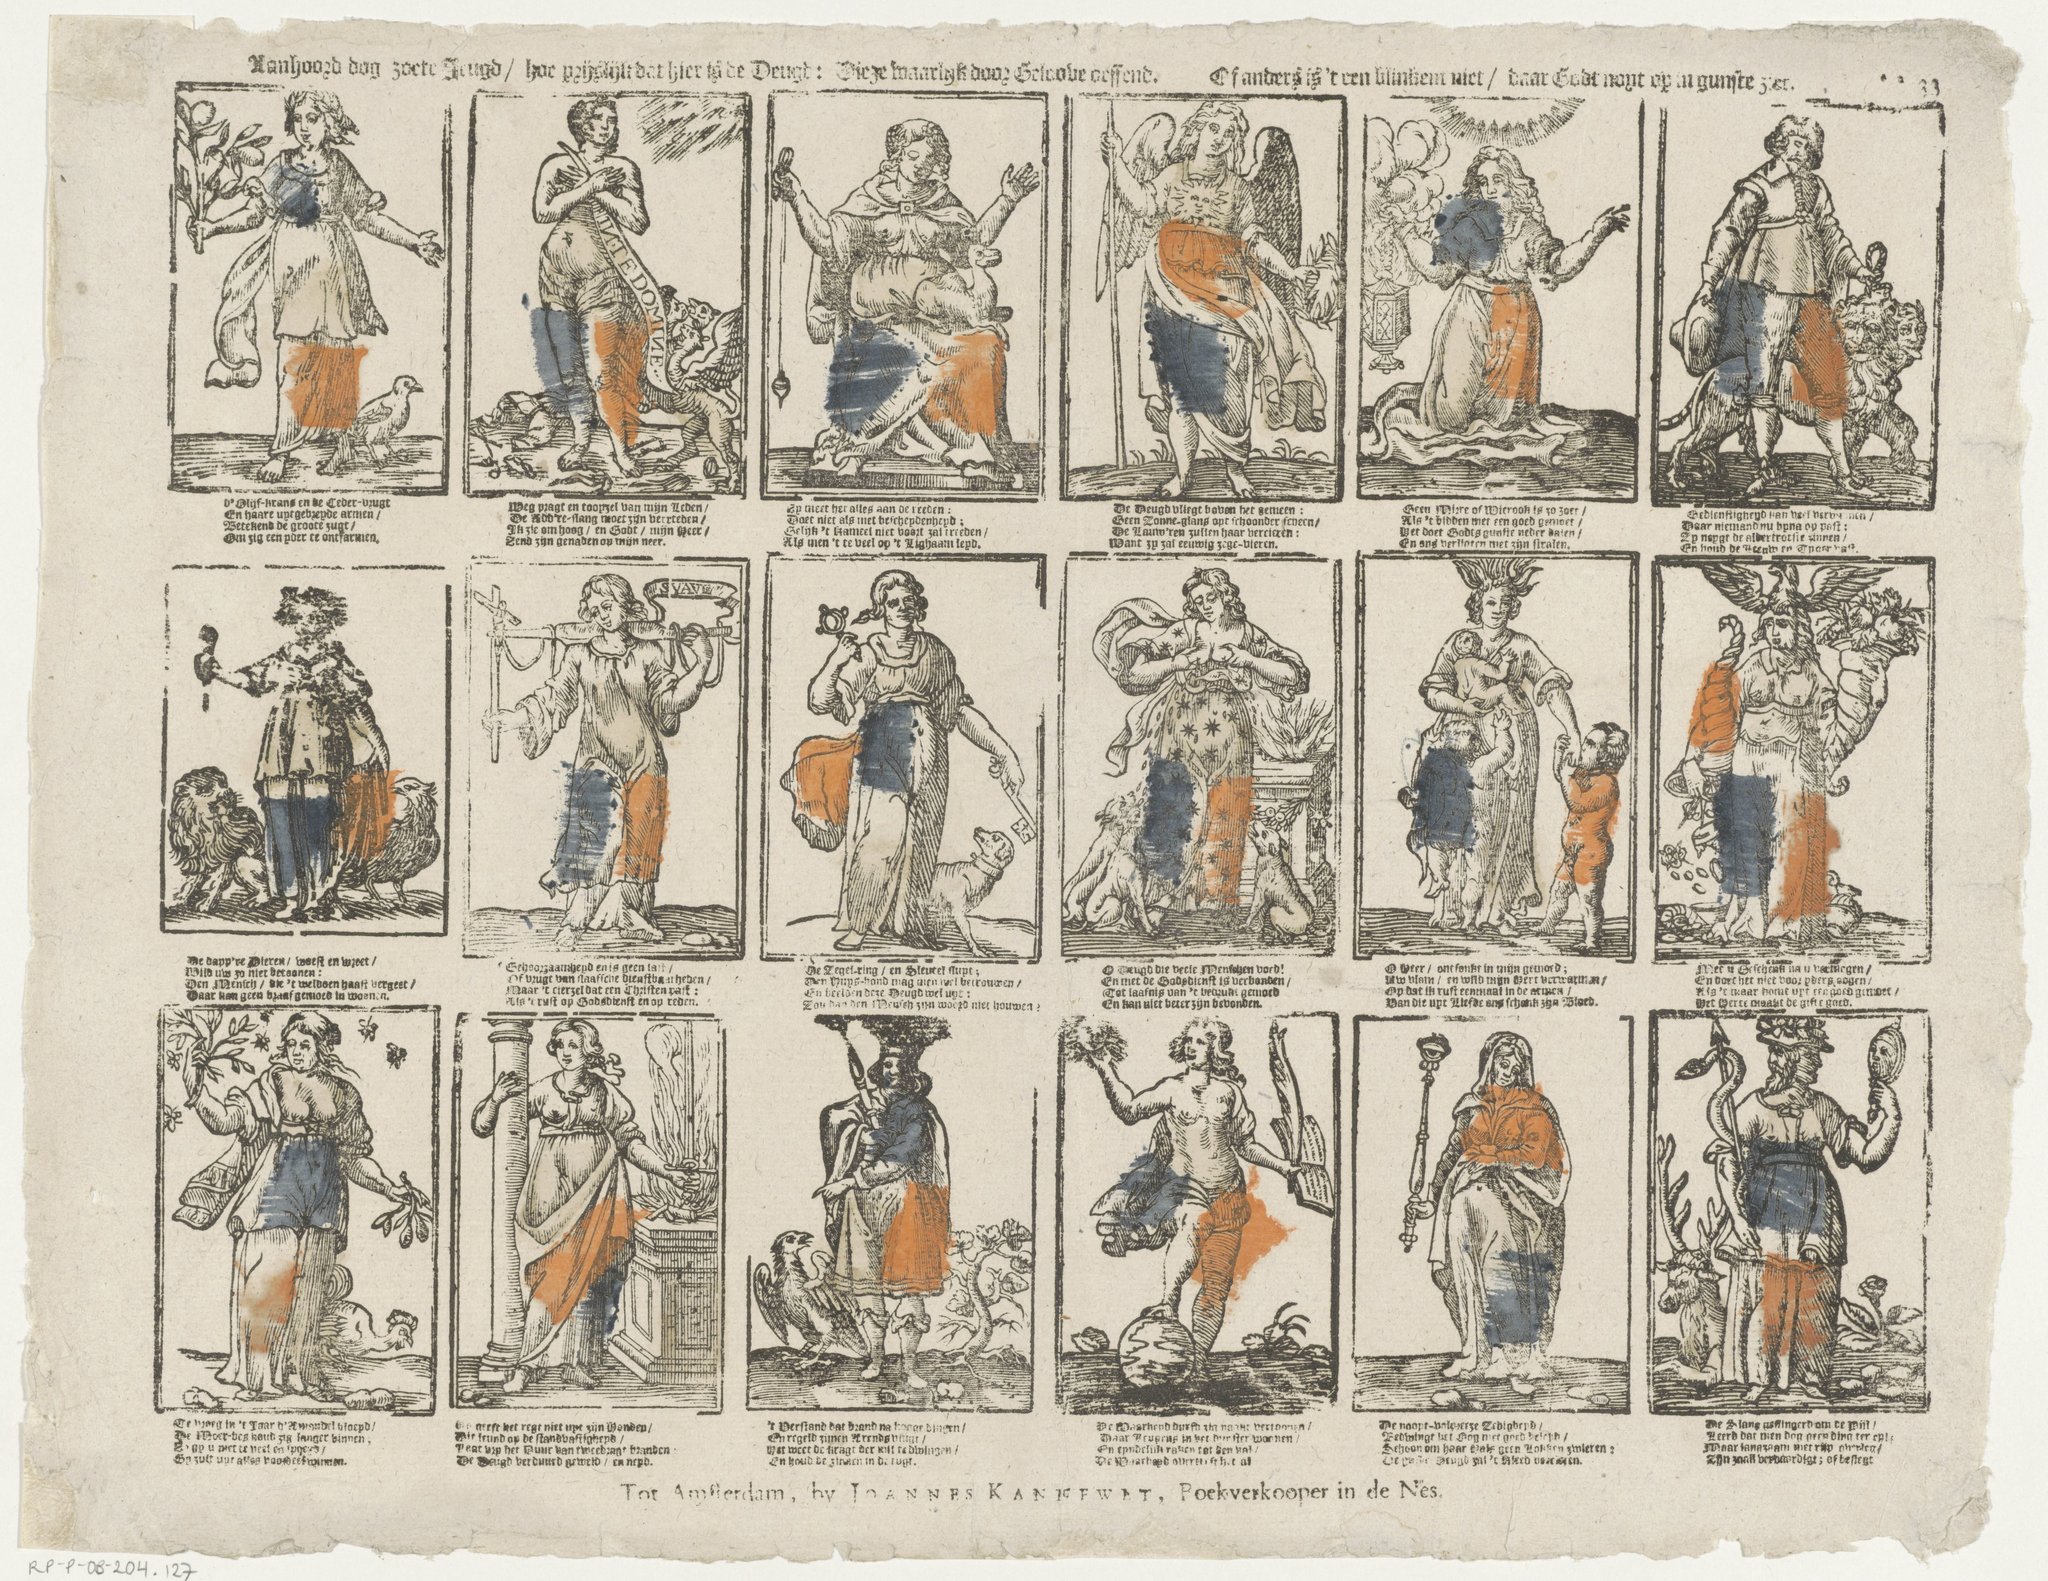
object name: popular print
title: Aanhoord dog zoete jeugd / hoe prijslijk dat hier is de deugd [(...)]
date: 1725-1780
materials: paper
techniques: colour, letterpress printing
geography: netherlands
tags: charity, 'caritas'; 'carità' (ripa) ~ one of the three theological virtues, prudence, 'prudentia'; 'prudenza' (ripa) ~ one of the four cardinal virtues, intellect, intelligence; 'intelletto', 'intelligenza' (ripa)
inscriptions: collector's mark: Lugt 2760, inscription: ‘C.’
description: Blad met 18 voorstellingen van allegorische figuren. Onder elke afbeelding een vierrgelig vers. Genummerd rechtsboven: **33.